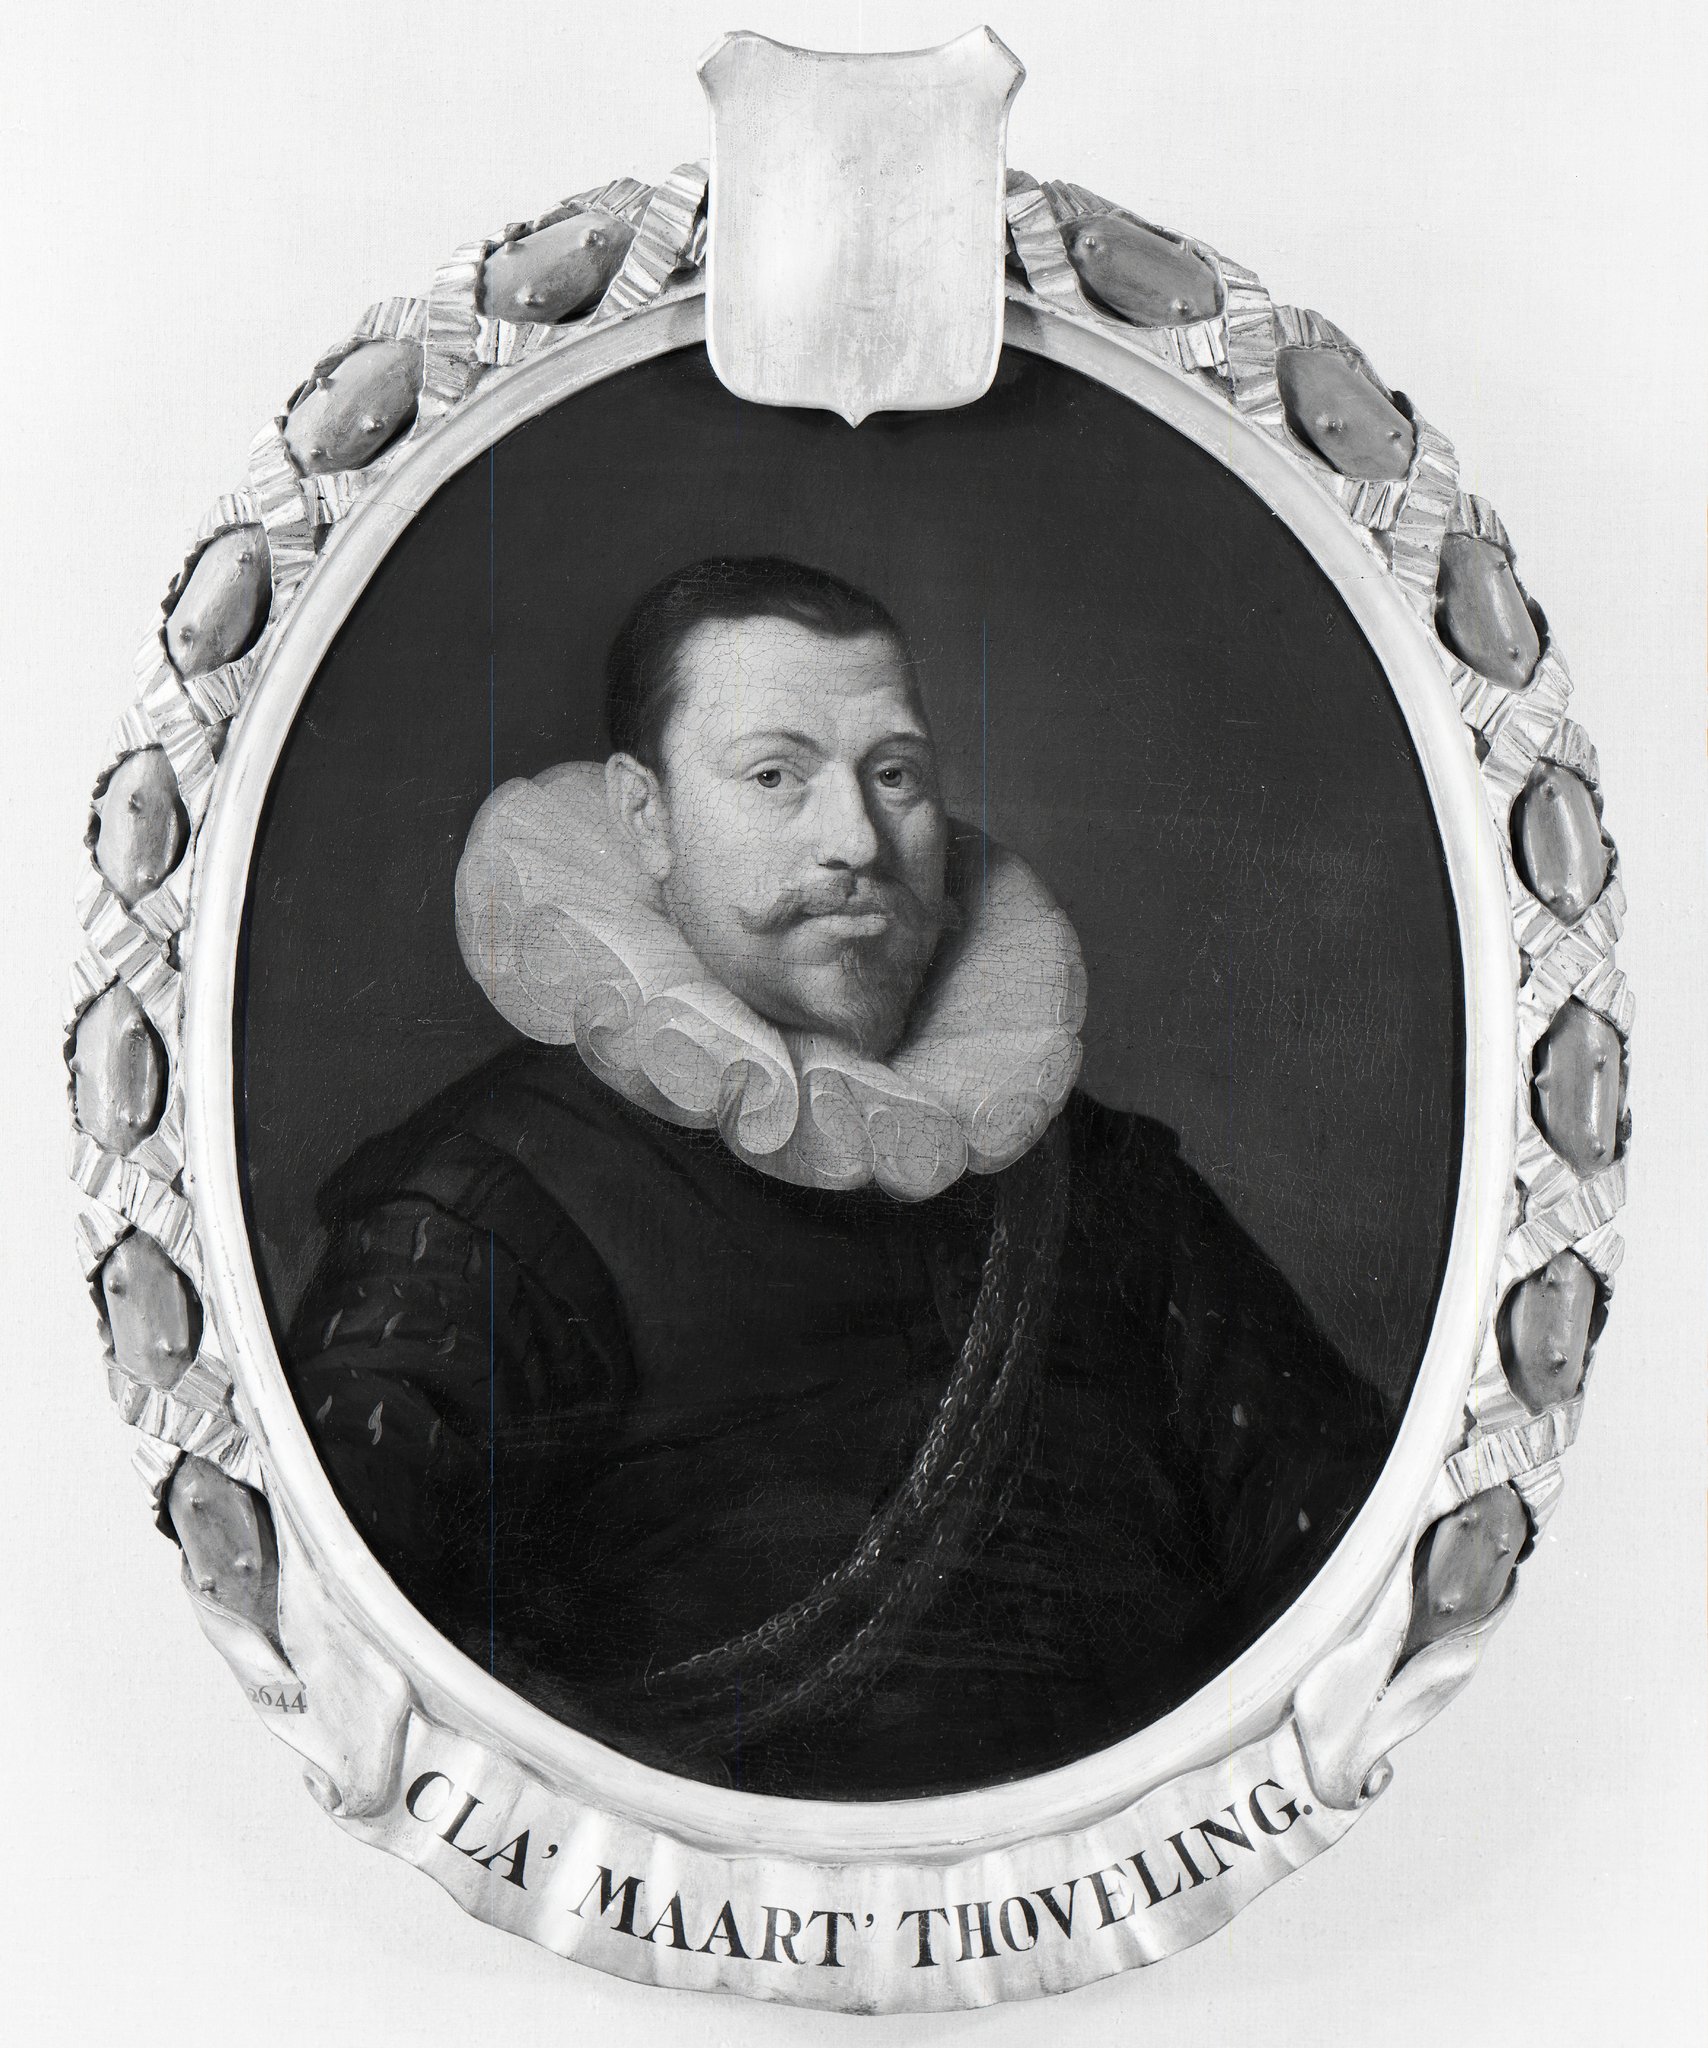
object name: painting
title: Portrait of Claes Maertensz Thoveling, Director of the Rotterdam Chamber of the Dutch East India Company, elected 1619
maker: pieter van der werff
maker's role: draughtsman, painter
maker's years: 1665-1722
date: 1695-1722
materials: canvas, oil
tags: rotterdam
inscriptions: inscription: ‘Cla' Maart' Thoveling.’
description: Portret van Claes Maertensz Thoveling, gekozen in 1619. Buste in ovaal naar rechts. Onderdeel van een reeks portretten van de bewindhebbers van de Rotterdamse Kamer van de Verenigde Oost-Indische Compagnie, vervaardigd voor het Nieuw Oost-Indisch Huis uit 1698 aan de Boompjes te Rotterdam.